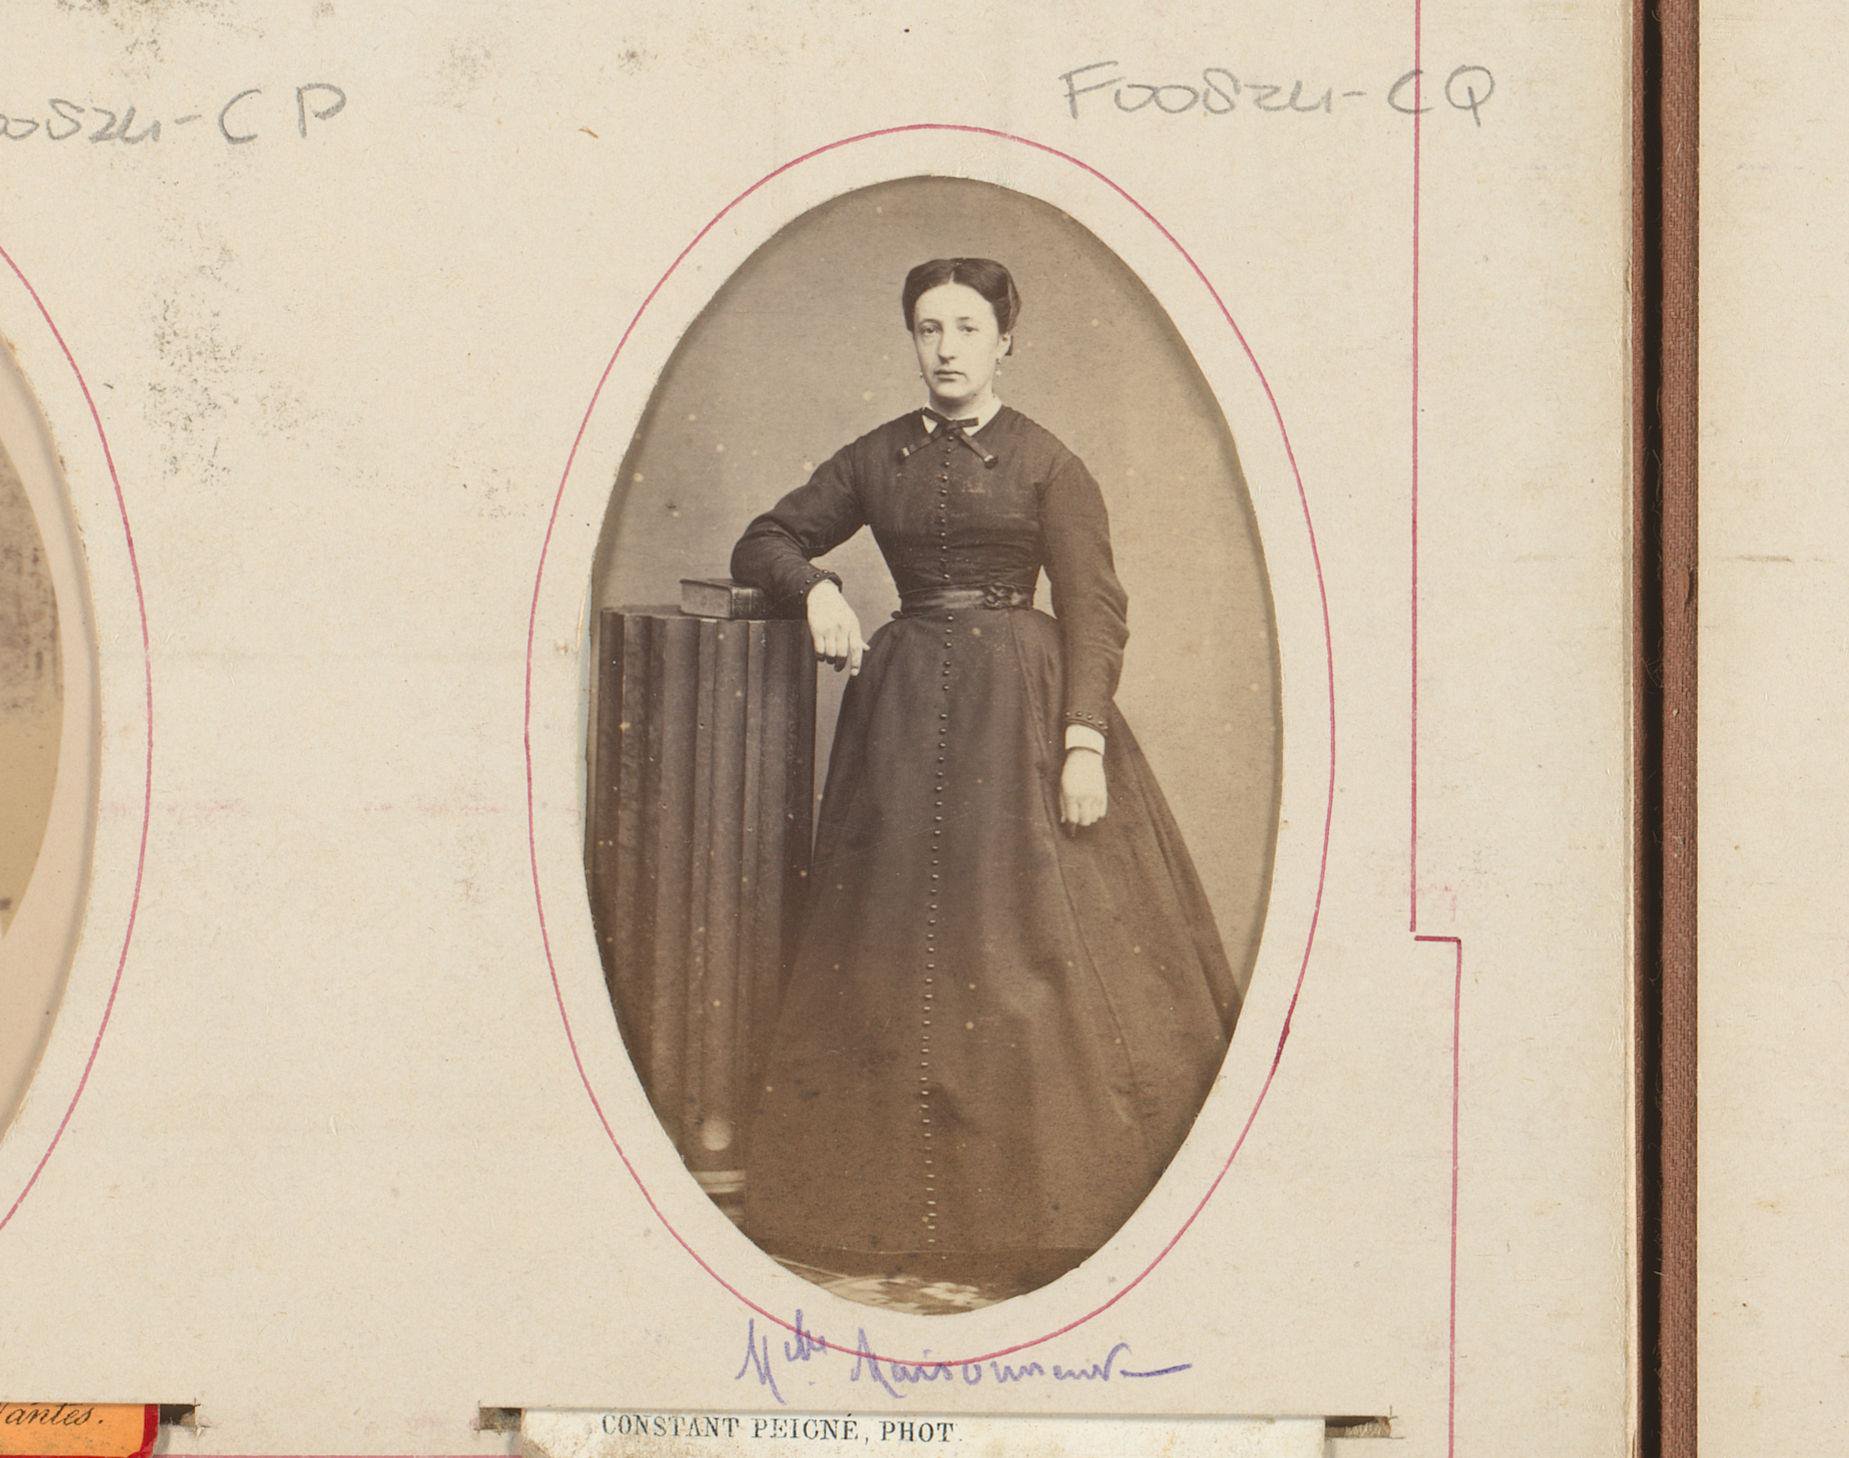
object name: photograph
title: Portret van een vrouw, aangeduid als Mlle. Maisonneur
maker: constant peigné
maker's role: fotograaf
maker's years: 1834-1916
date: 1861-1868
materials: cardboard, paper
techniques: albumen print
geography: nantes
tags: adult woman, anonymous historical person portrayed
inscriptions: inscription: ‘No du Cliché 11986/ pour avoir ce portrait sans poser, envoyer le No ci-/ dessus, la maison conserve les clichés indéfiniment’, address: ‘40, Rue Contrescarpe, 40/ près la place bretagne/ NANTES’